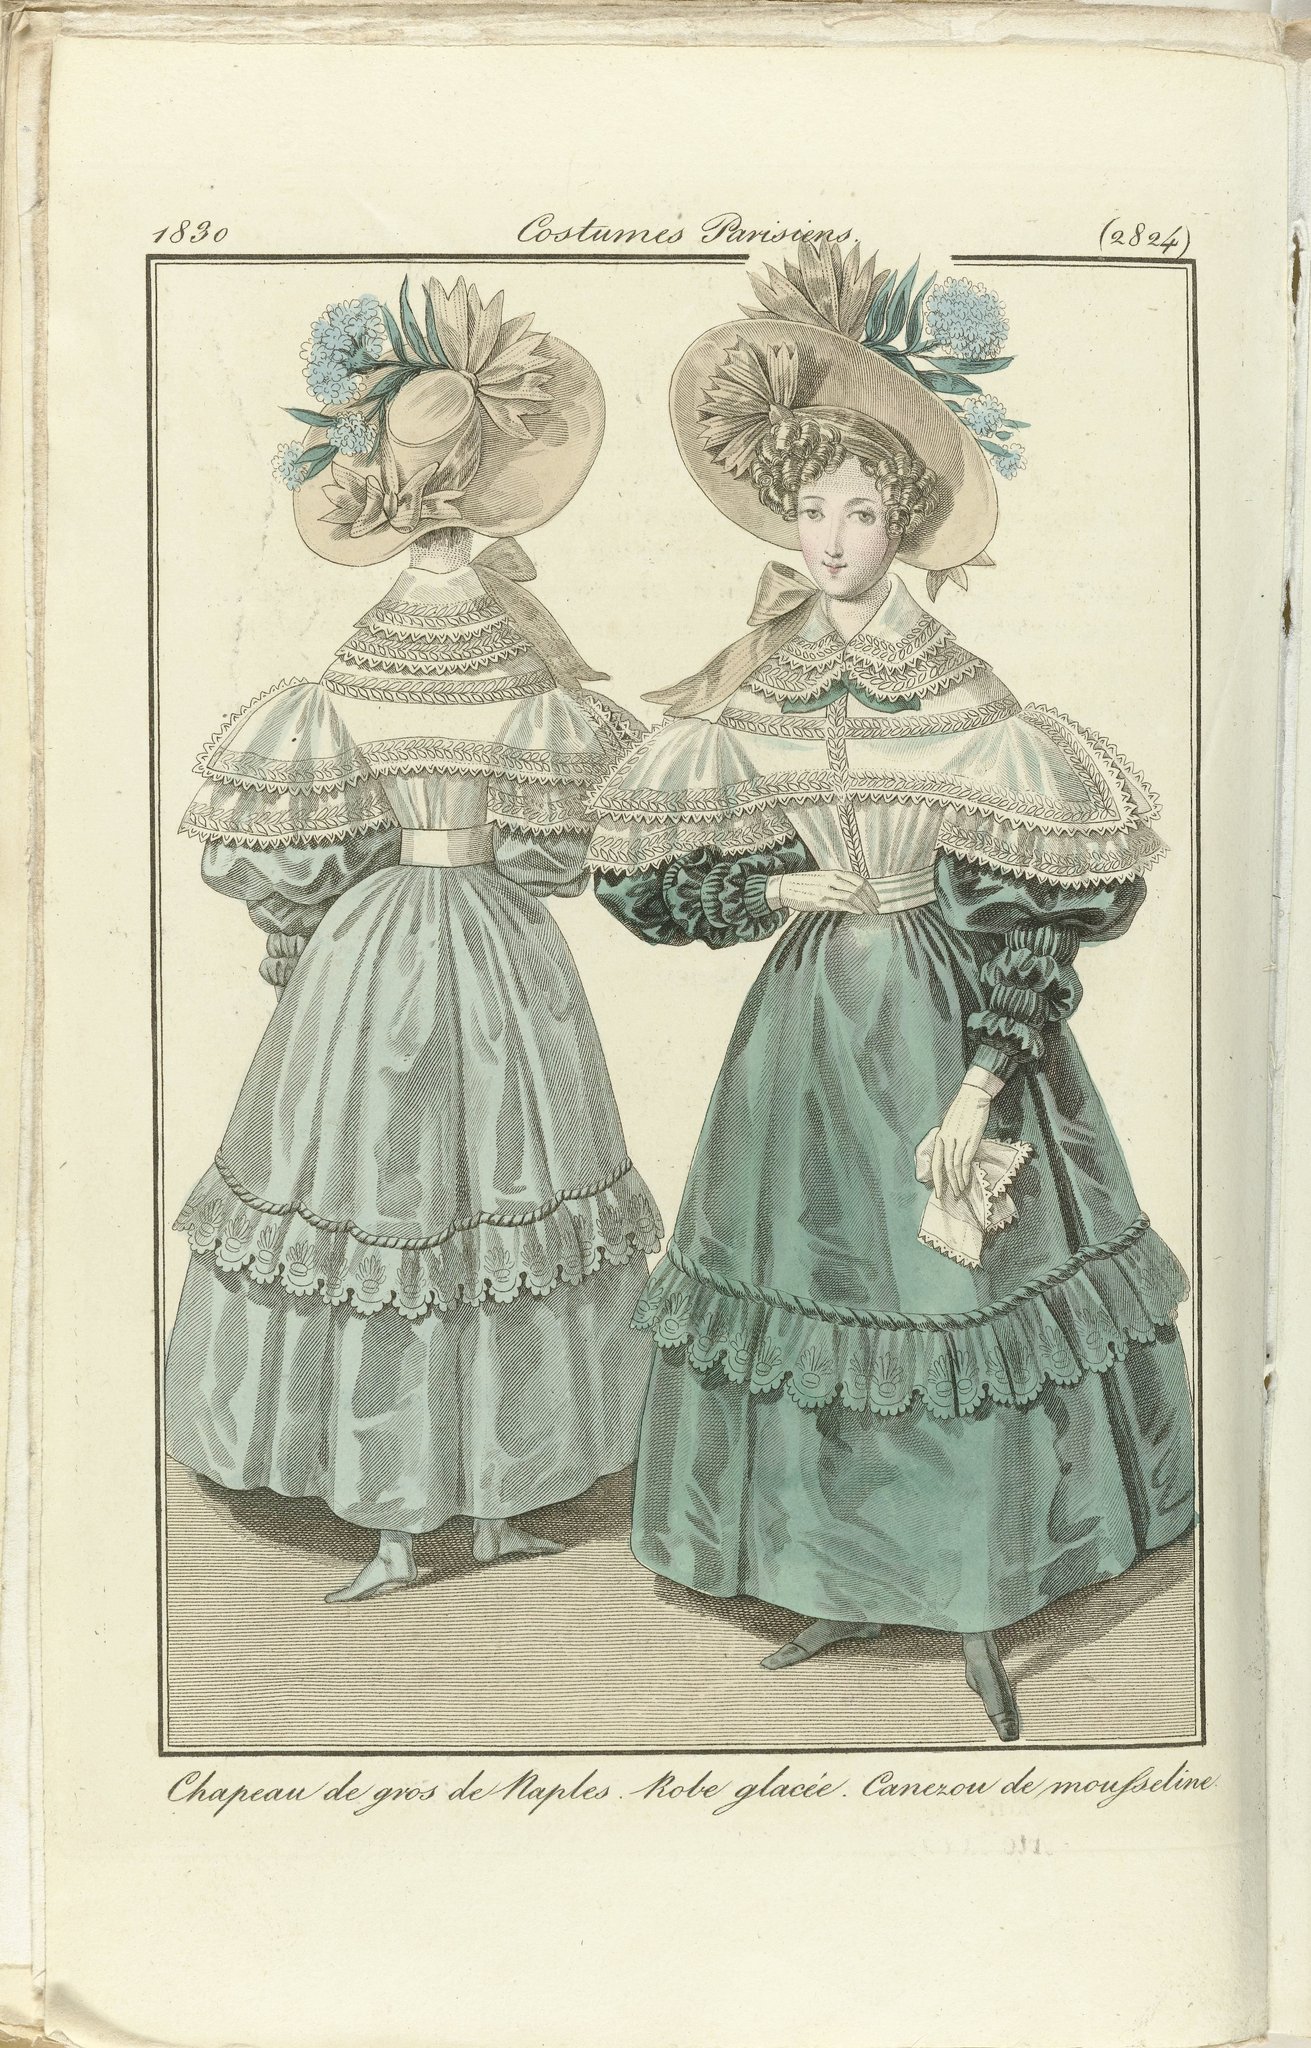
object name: fashion print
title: Journal des Dames et des Modes 1830, Costumes Parisiens (2824)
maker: Anonymous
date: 1830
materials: paper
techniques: etching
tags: fashion plates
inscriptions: date